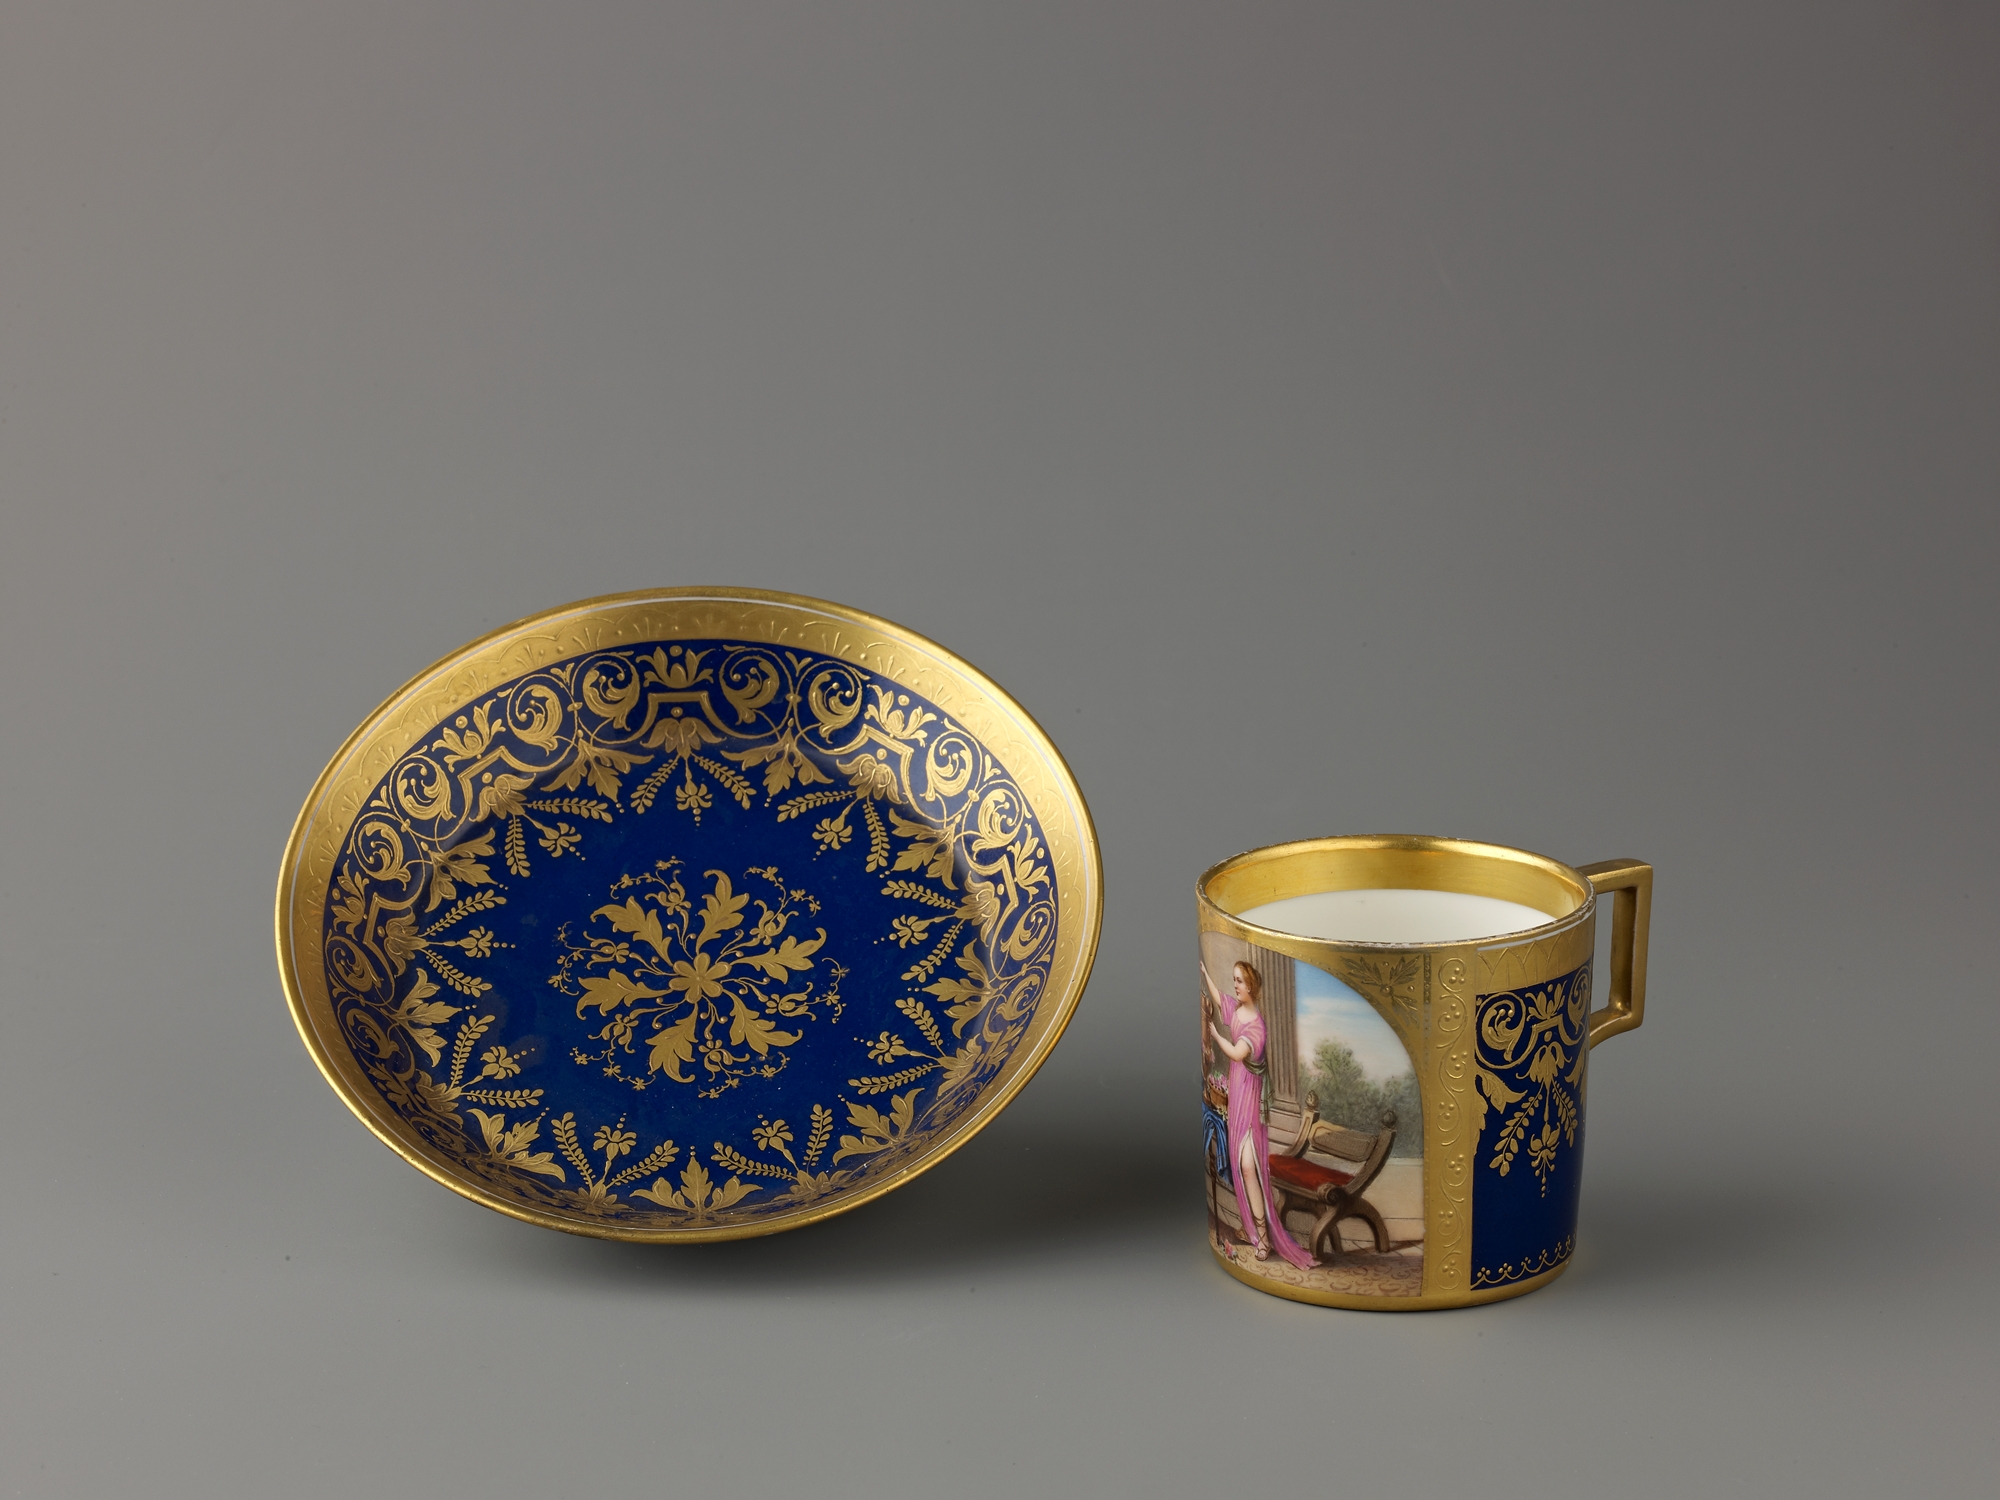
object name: cup and saucer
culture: austrian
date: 1901-2000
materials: hard paste porcelain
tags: women